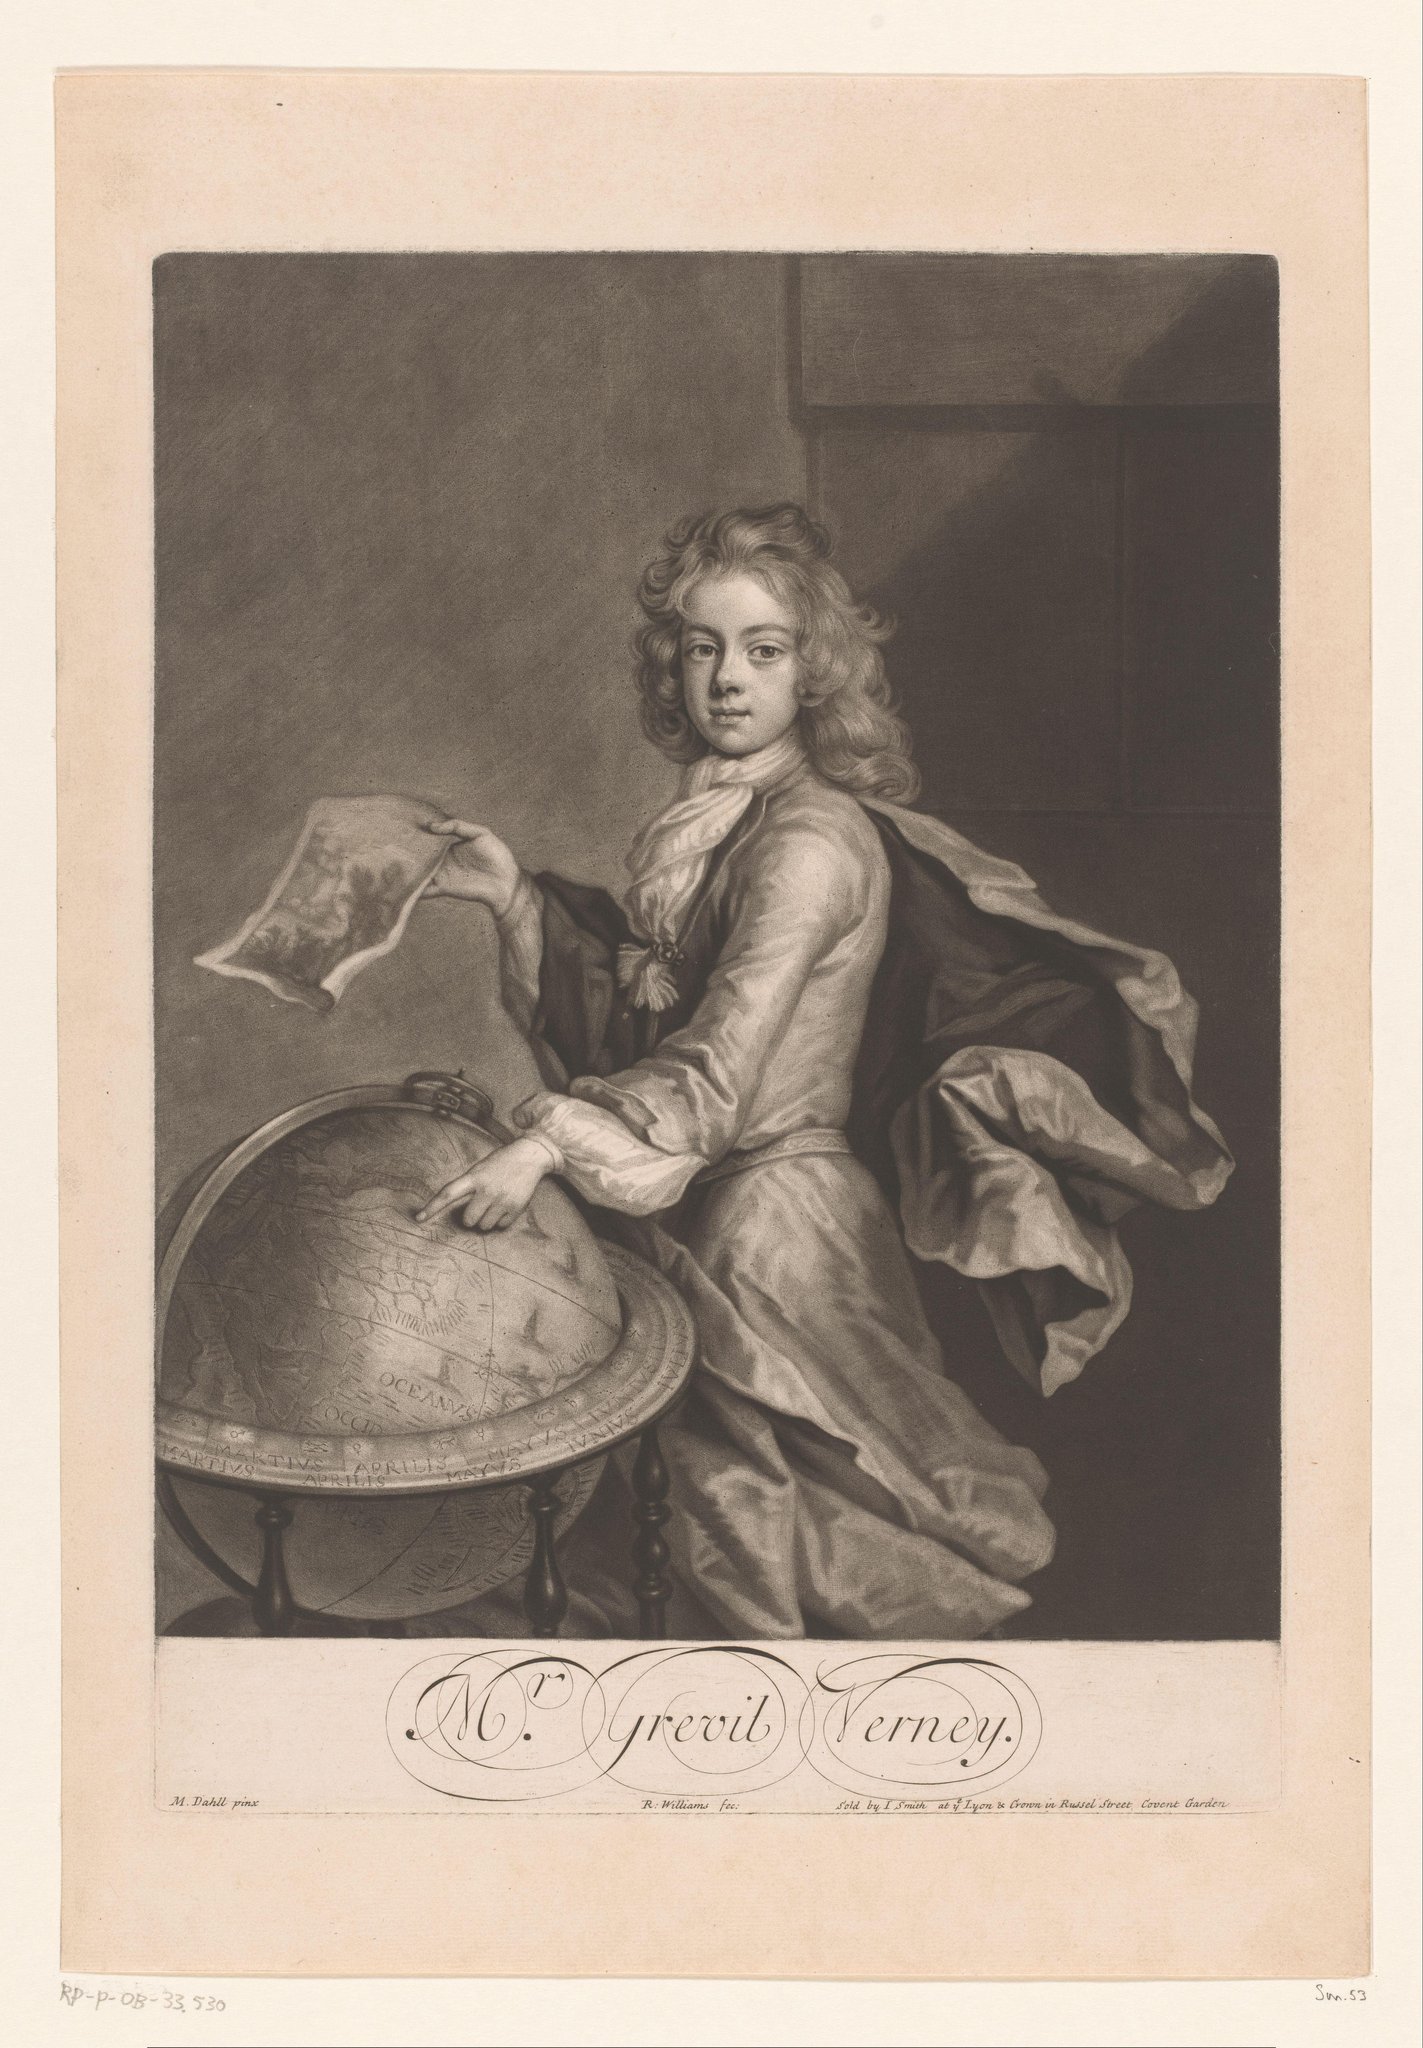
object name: print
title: Mr. Grevil Verney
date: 1690-1742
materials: paper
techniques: mezzotint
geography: london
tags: boy (child between toddler and youth), historical persons, globe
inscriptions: collector's mark: Lugt 240